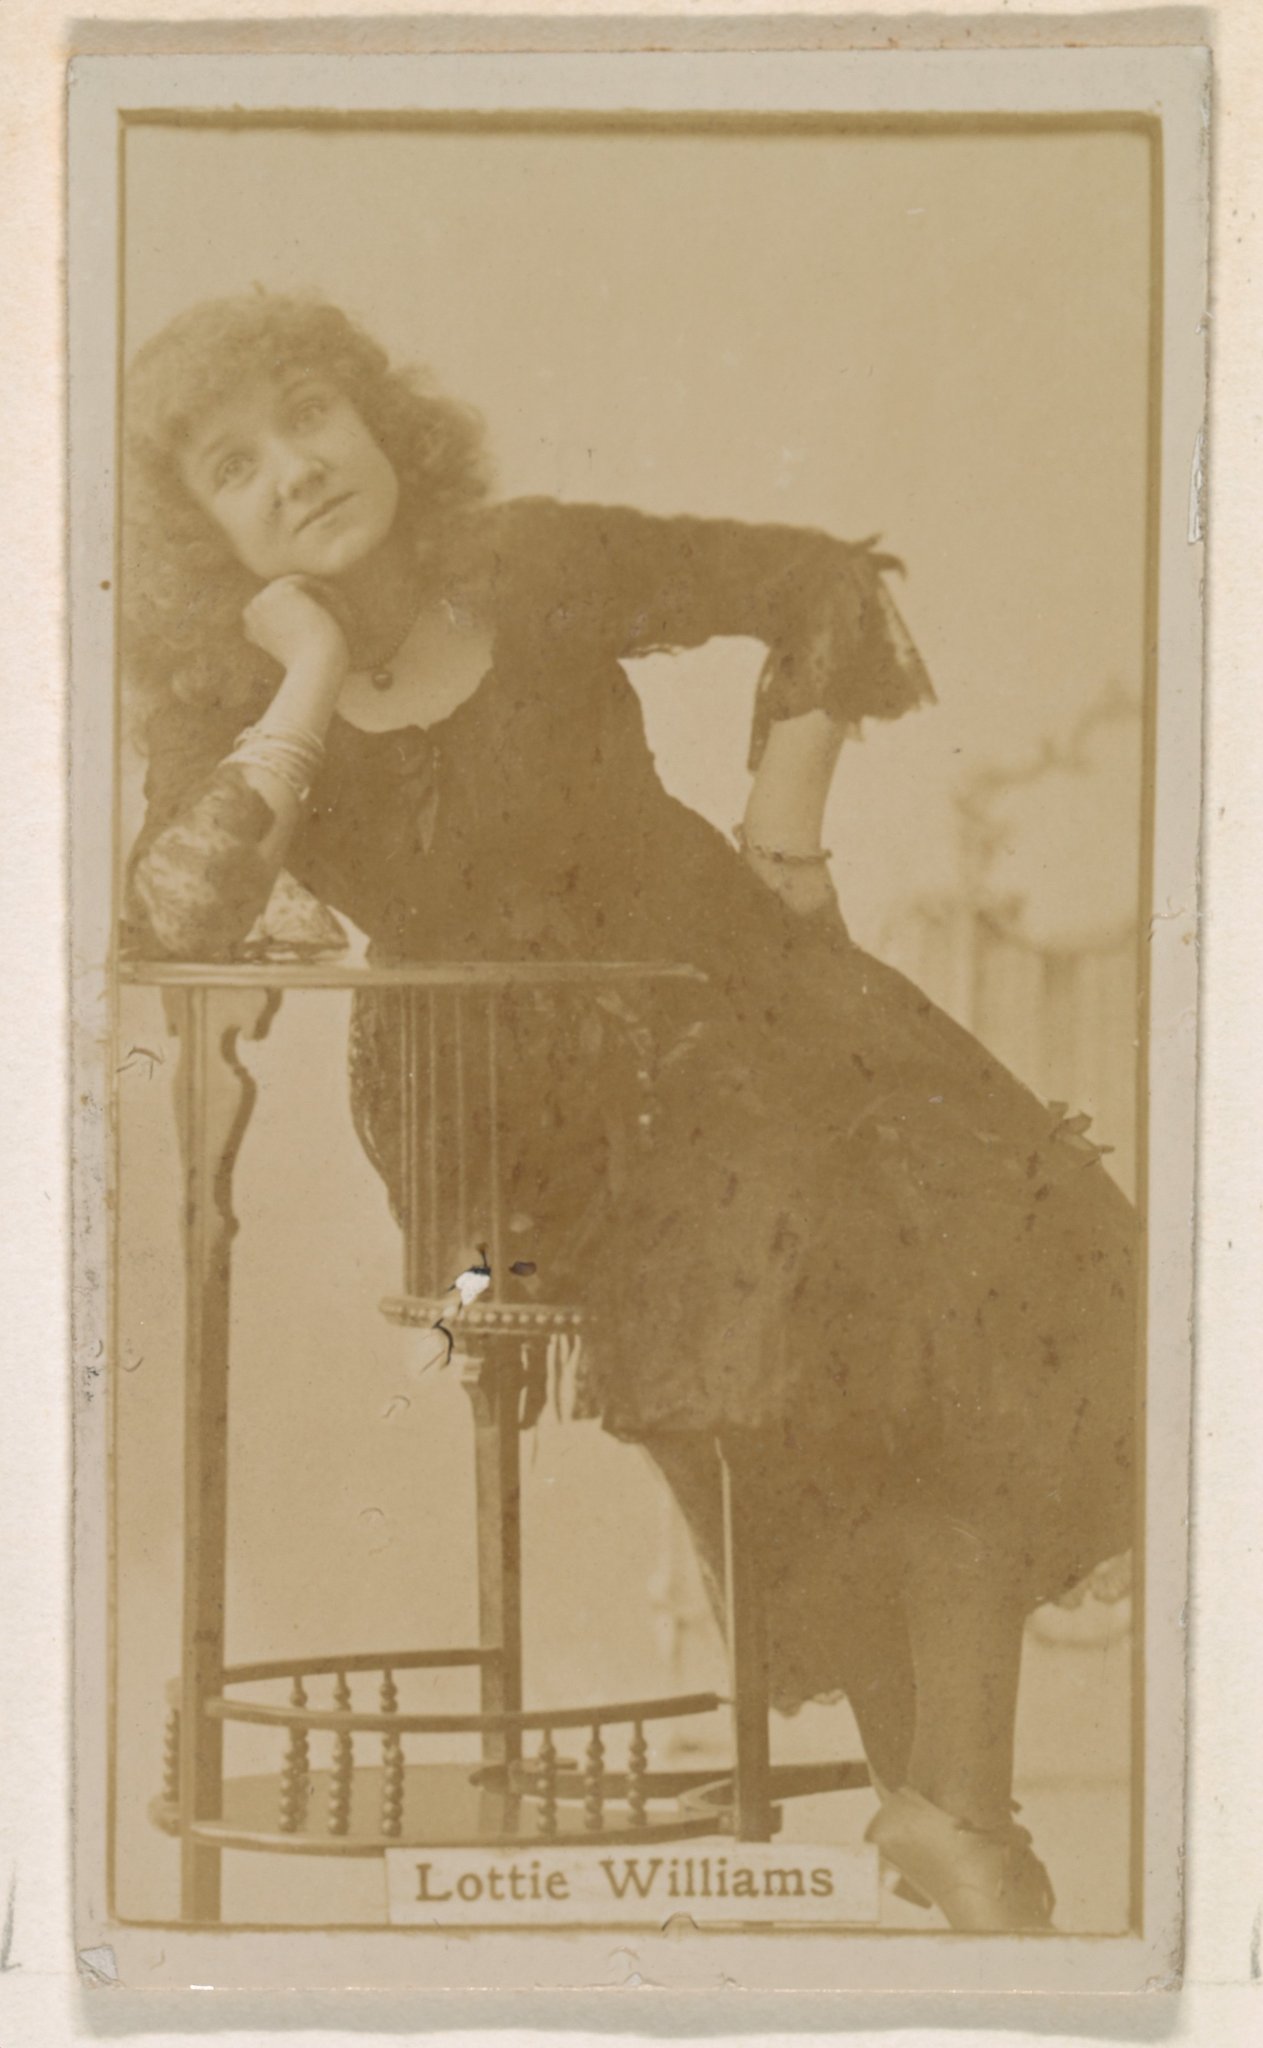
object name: photograph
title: Lottie Williams, from the Actresses series (N245) issued by Kinney Brothers to promote Sweet Caporal Cigarettes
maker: kinney brothers tobacco company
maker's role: publisher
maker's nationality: american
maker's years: 1869-2011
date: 1890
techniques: albumen silver print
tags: portraits,women,actresses